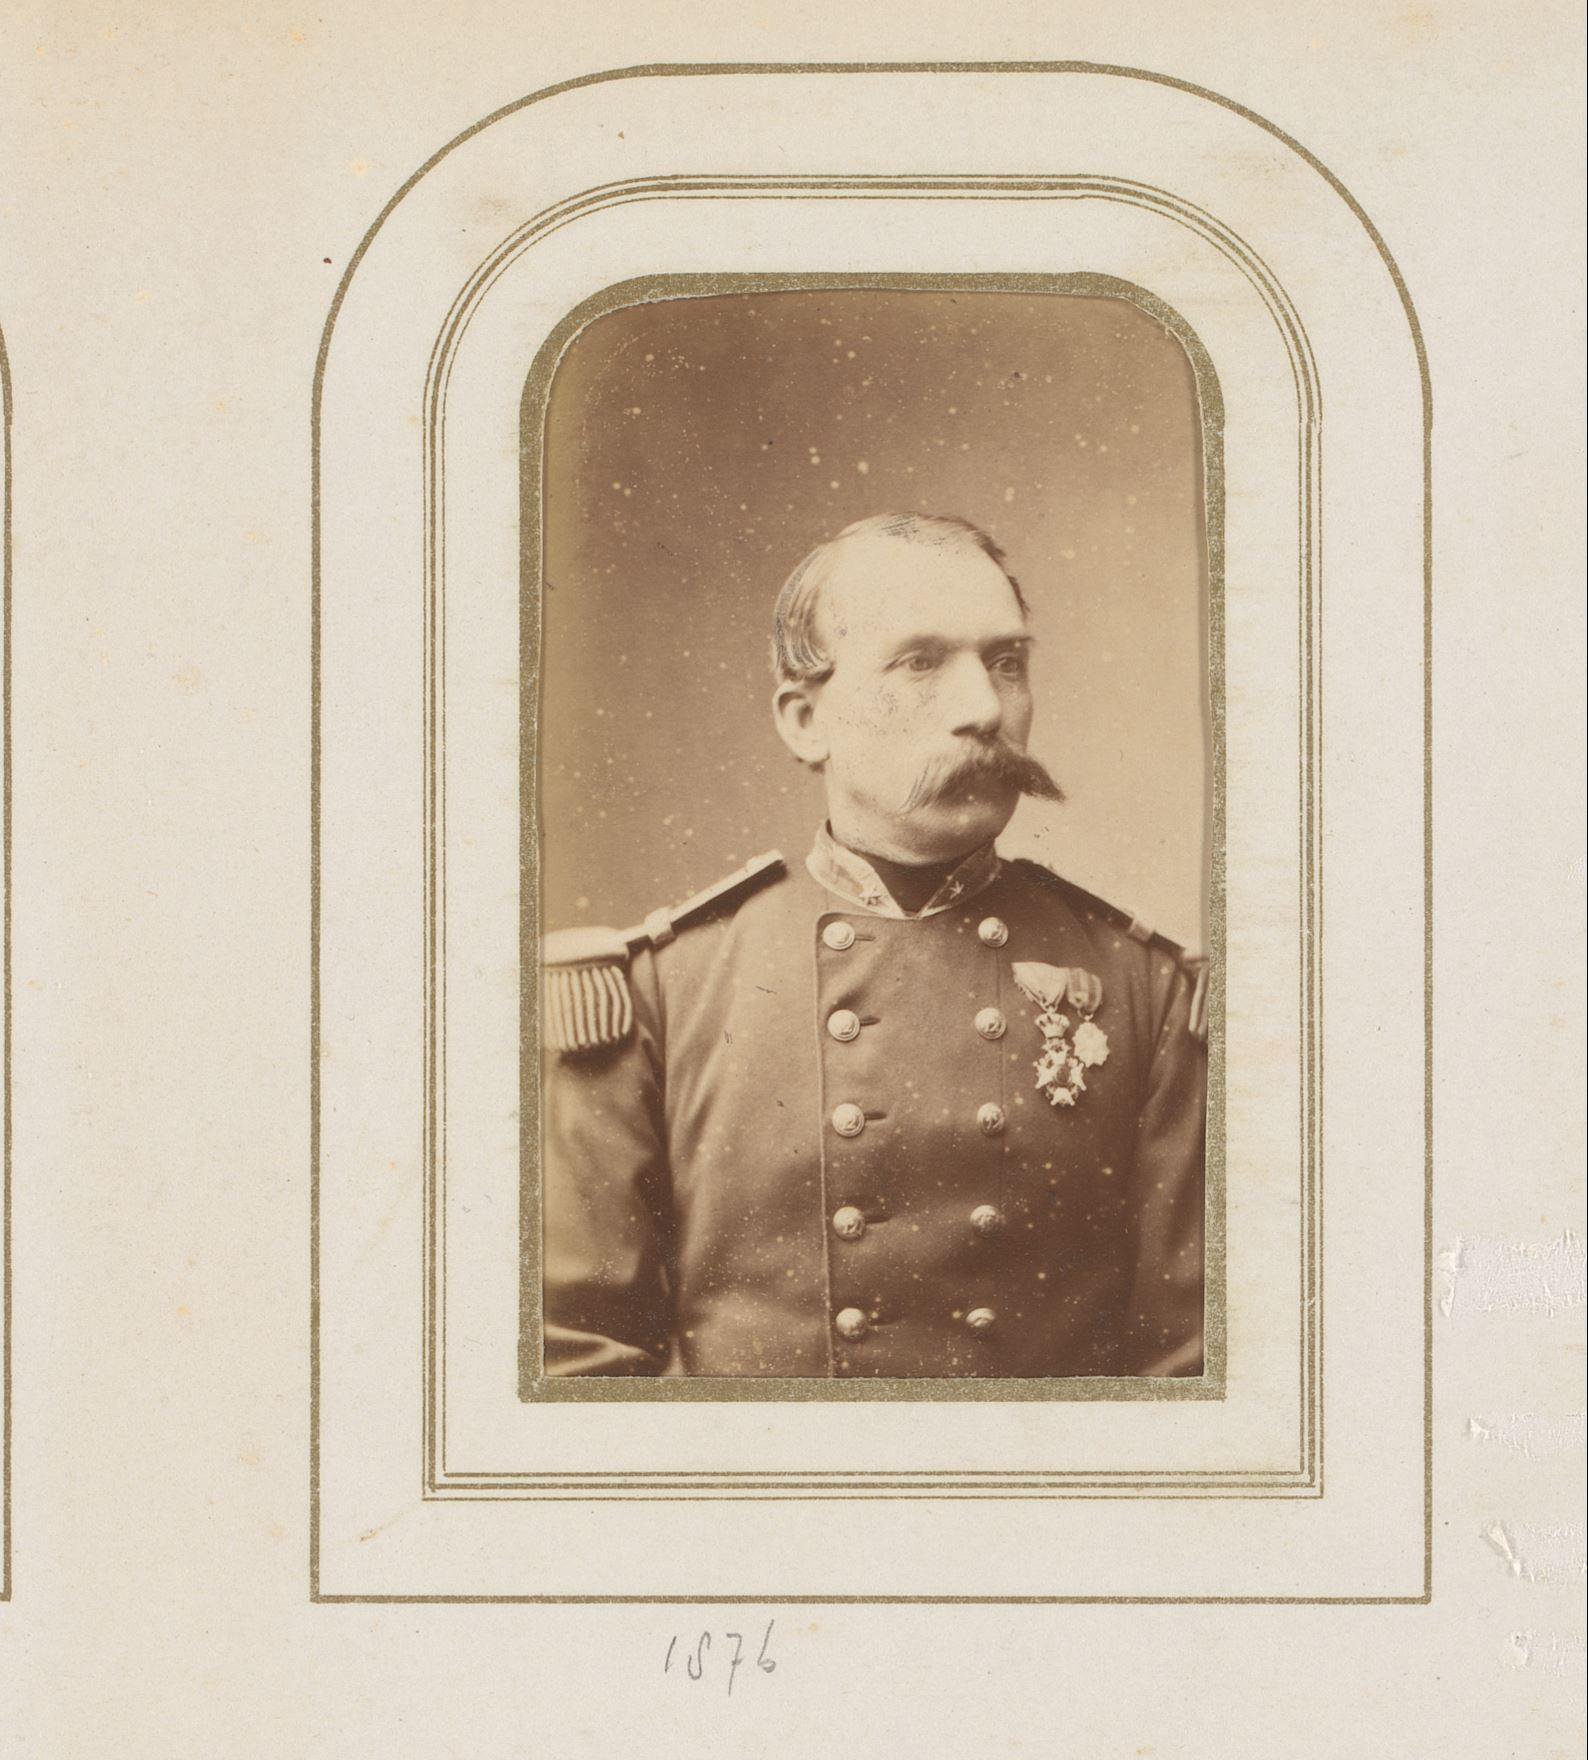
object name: album leaf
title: Portret van een man met snor in uniform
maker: adolph erkelenz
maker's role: fotograaf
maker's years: 1831-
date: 1876-1877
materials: cardboard, photographic support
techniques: albumen print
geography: liège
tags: moustache, historical persons, (military) uniforms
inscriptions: inscription: ‘Adolphe Erkelenz/ Liége/ 49bis Boulevard/ de la Sauvenière’, annotation: ‘A monsieur [...] Colonel Lemoine/ command 1 [...]/ témoignage de [...]/ 25 mars 1876/ [...]’